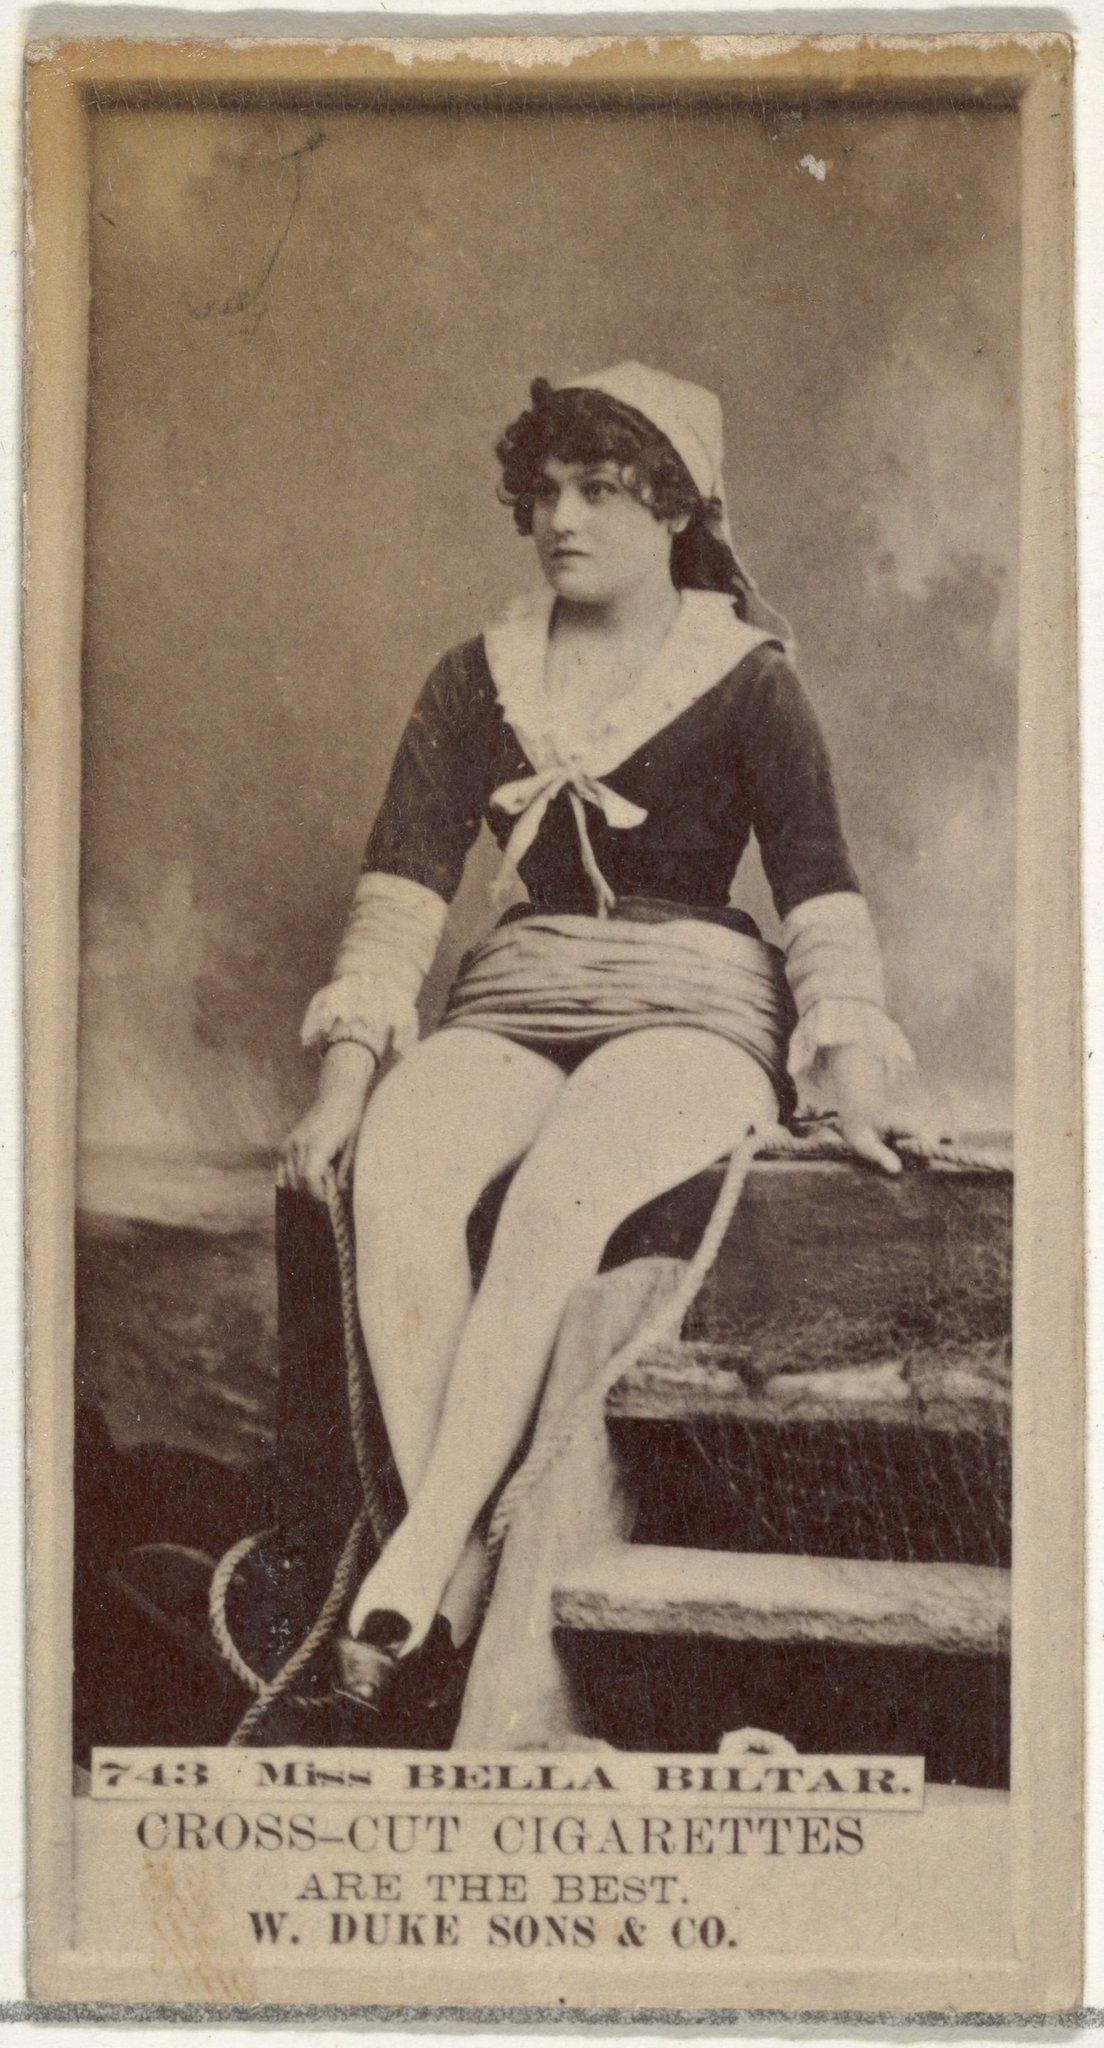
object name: photograph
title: Card Number 743, Miss Bella Biltar, from the Actors and Actresses series (N145-3) issued by Duke Sons & Co. to promote Cross Cut Cigarettes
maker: w. duke, sons & co.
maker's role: publisher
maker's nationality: american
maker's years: 1870-1920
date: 1880-1889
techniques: albumen silver print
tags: portraits,women,actresses